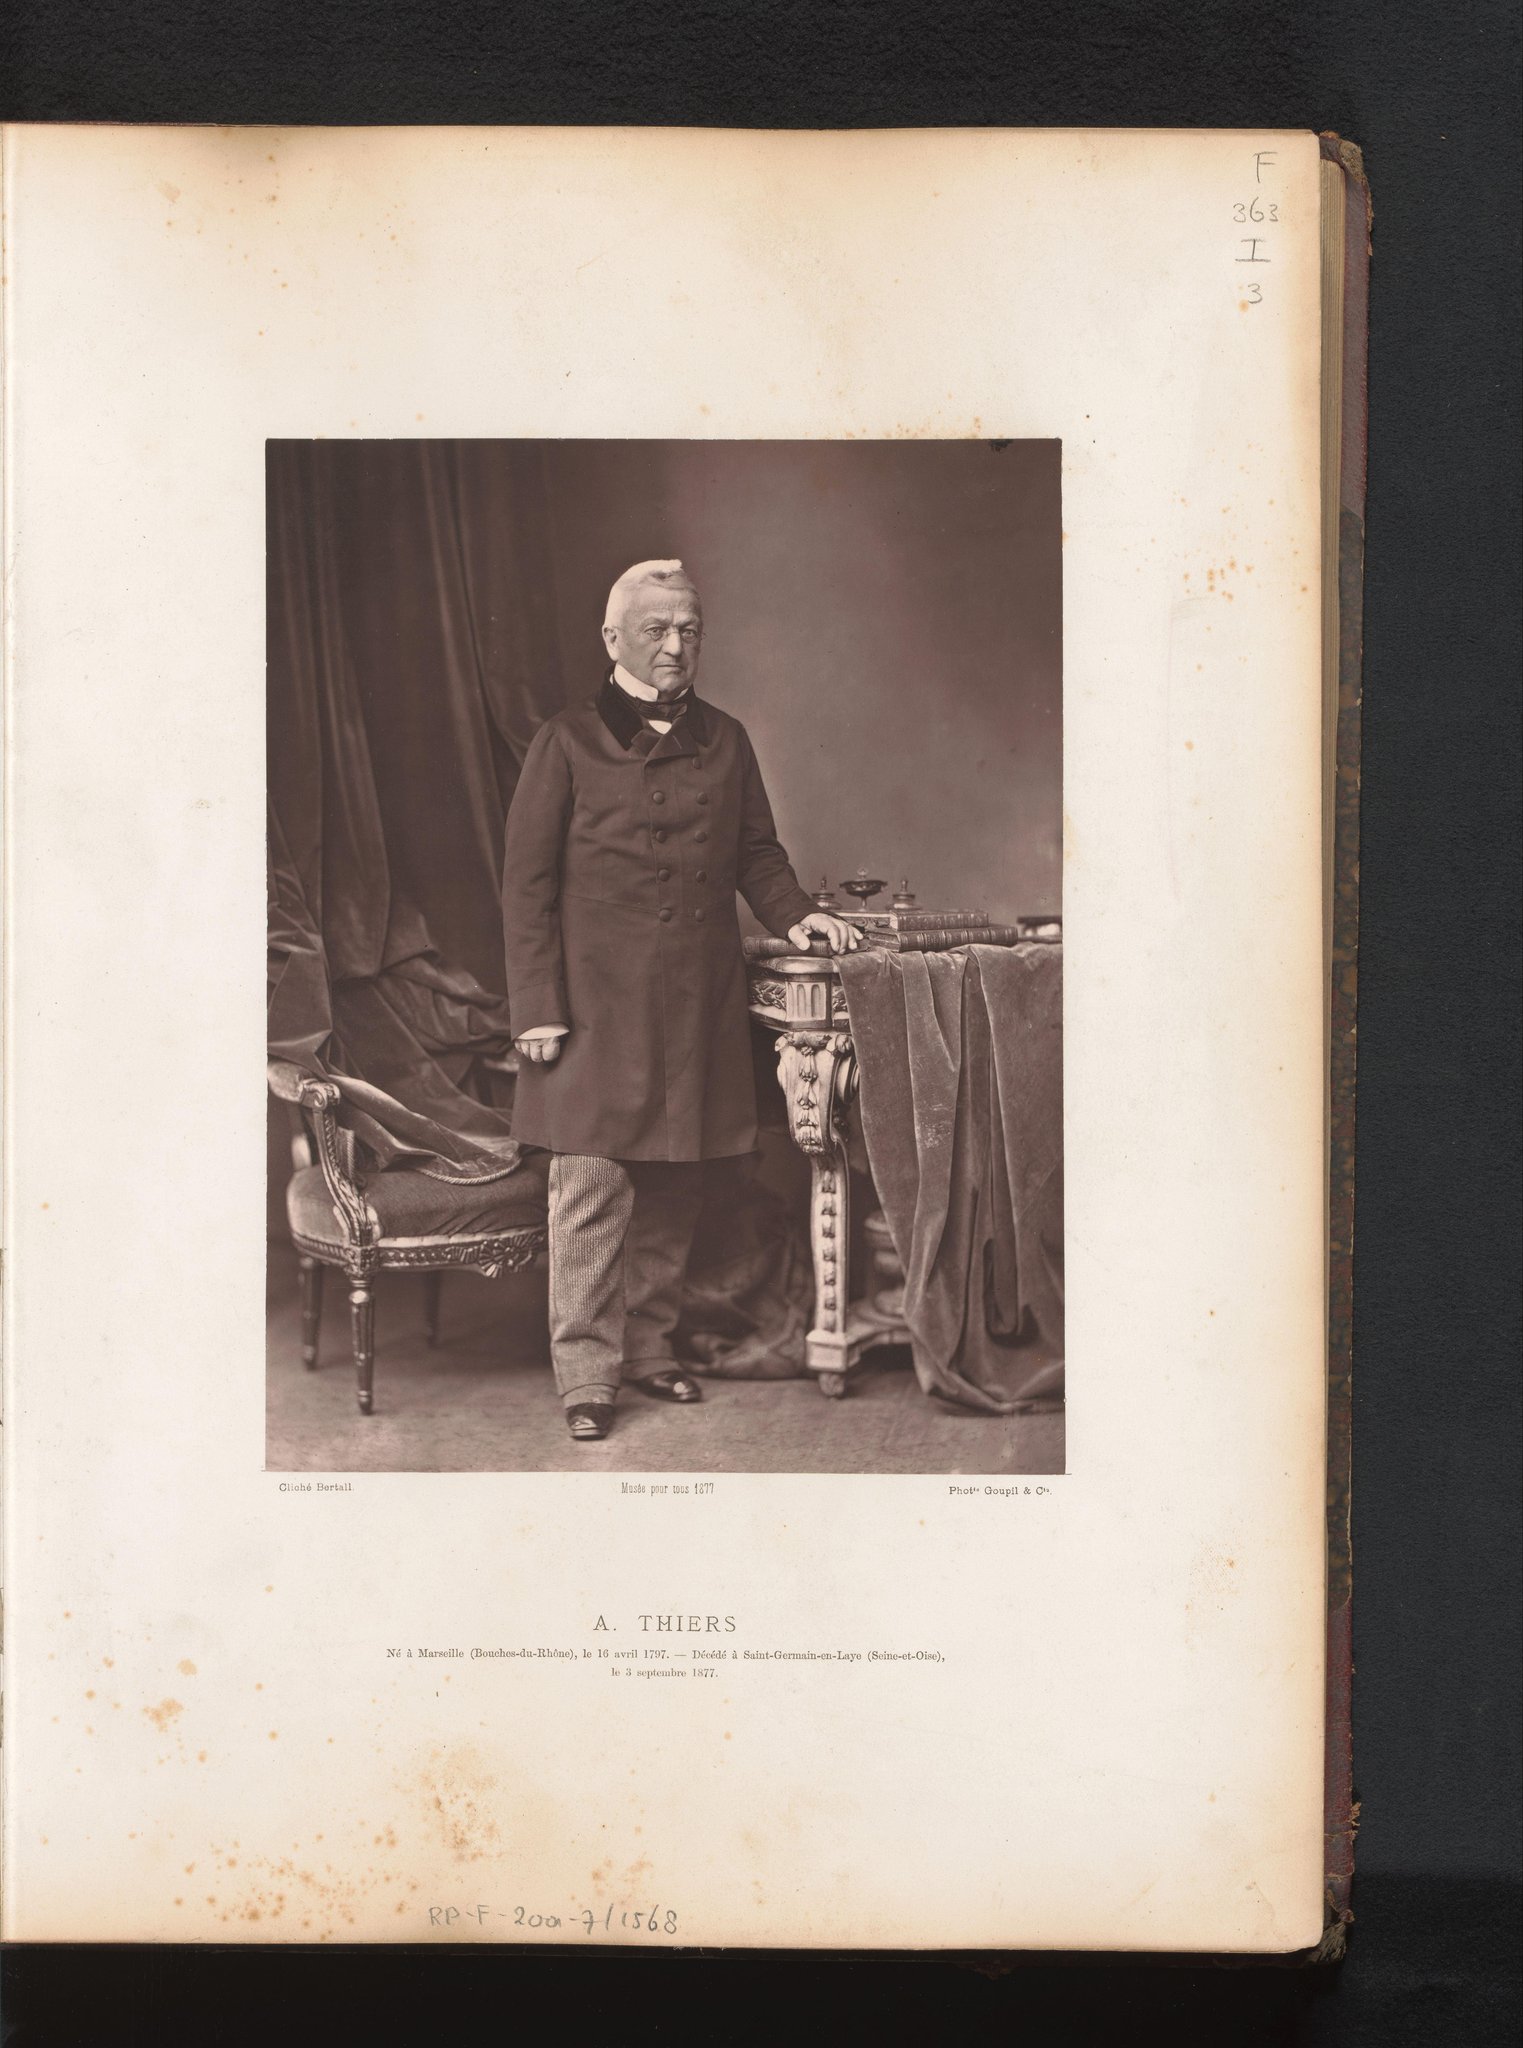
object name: photomechanical print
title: Portret van Louis-Adolphe Thiers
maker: m. bertall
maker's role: fotograaf, illustrator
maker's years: 1820-1882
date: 1872-1879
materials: paper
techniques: woodburytype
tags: marseille, politician, historical persons, politician, e.g. party leader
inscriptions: inscription: ‘Né à Marseille (Bouches-du-Rhône), le 16 avril 1797. - Décédé à Saint-Germain-en-Laye (Seine-et-Oise), le 3 septembre 1877.’, inscription: ‘Musée pour tous 1877’